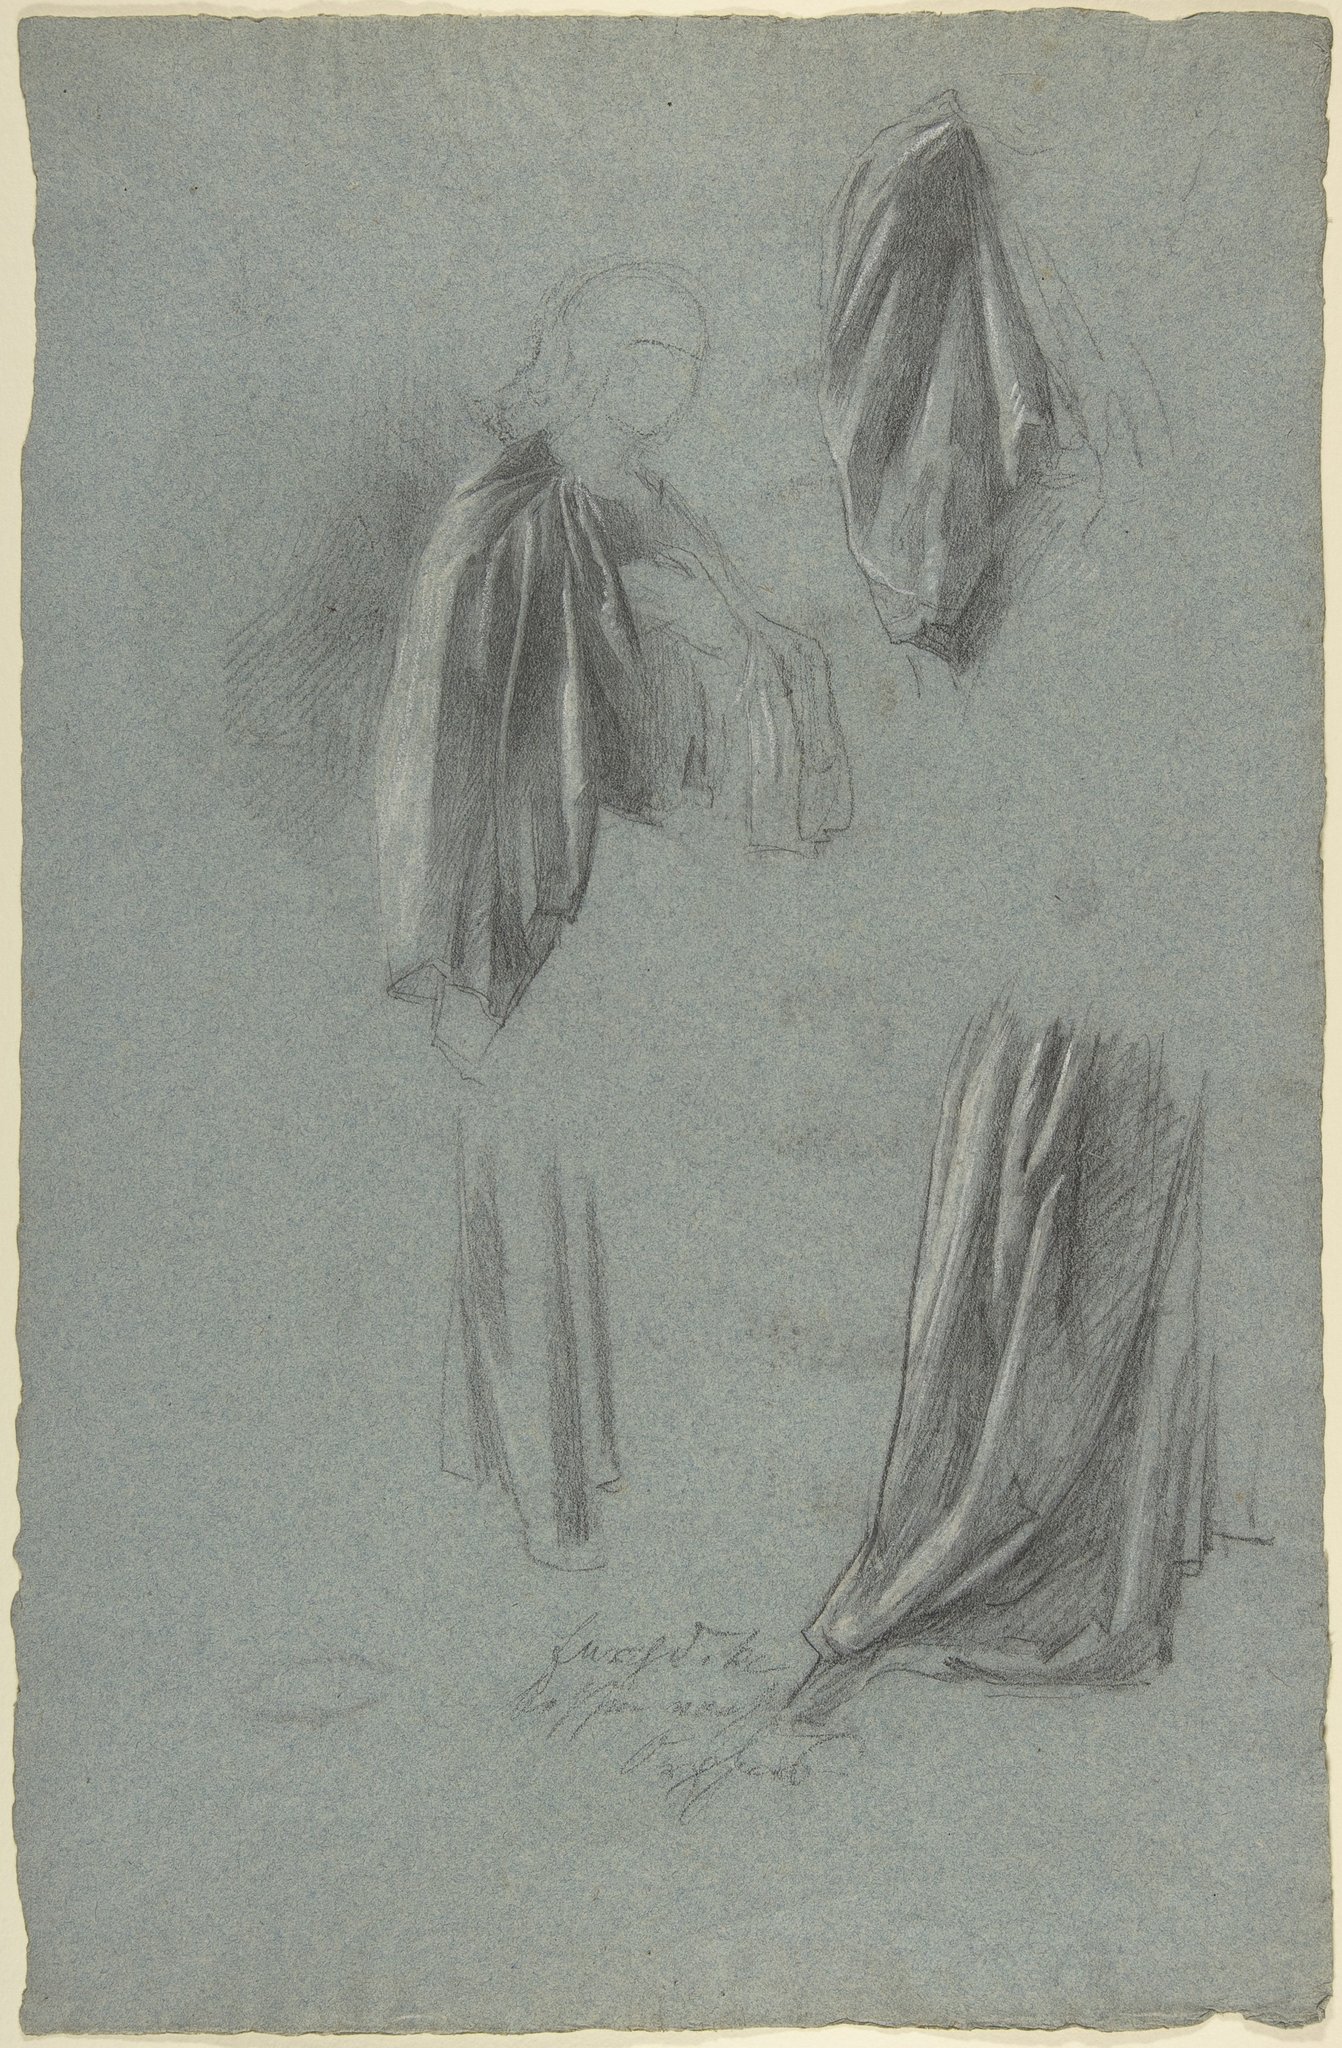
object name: drawing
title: Drapery Studies (recto); Drapery Studies (verso)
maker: anselm feuerbach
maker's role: artist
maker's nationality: german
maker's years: 1829-1880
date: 1829-1880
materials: chalk, paper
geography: germany